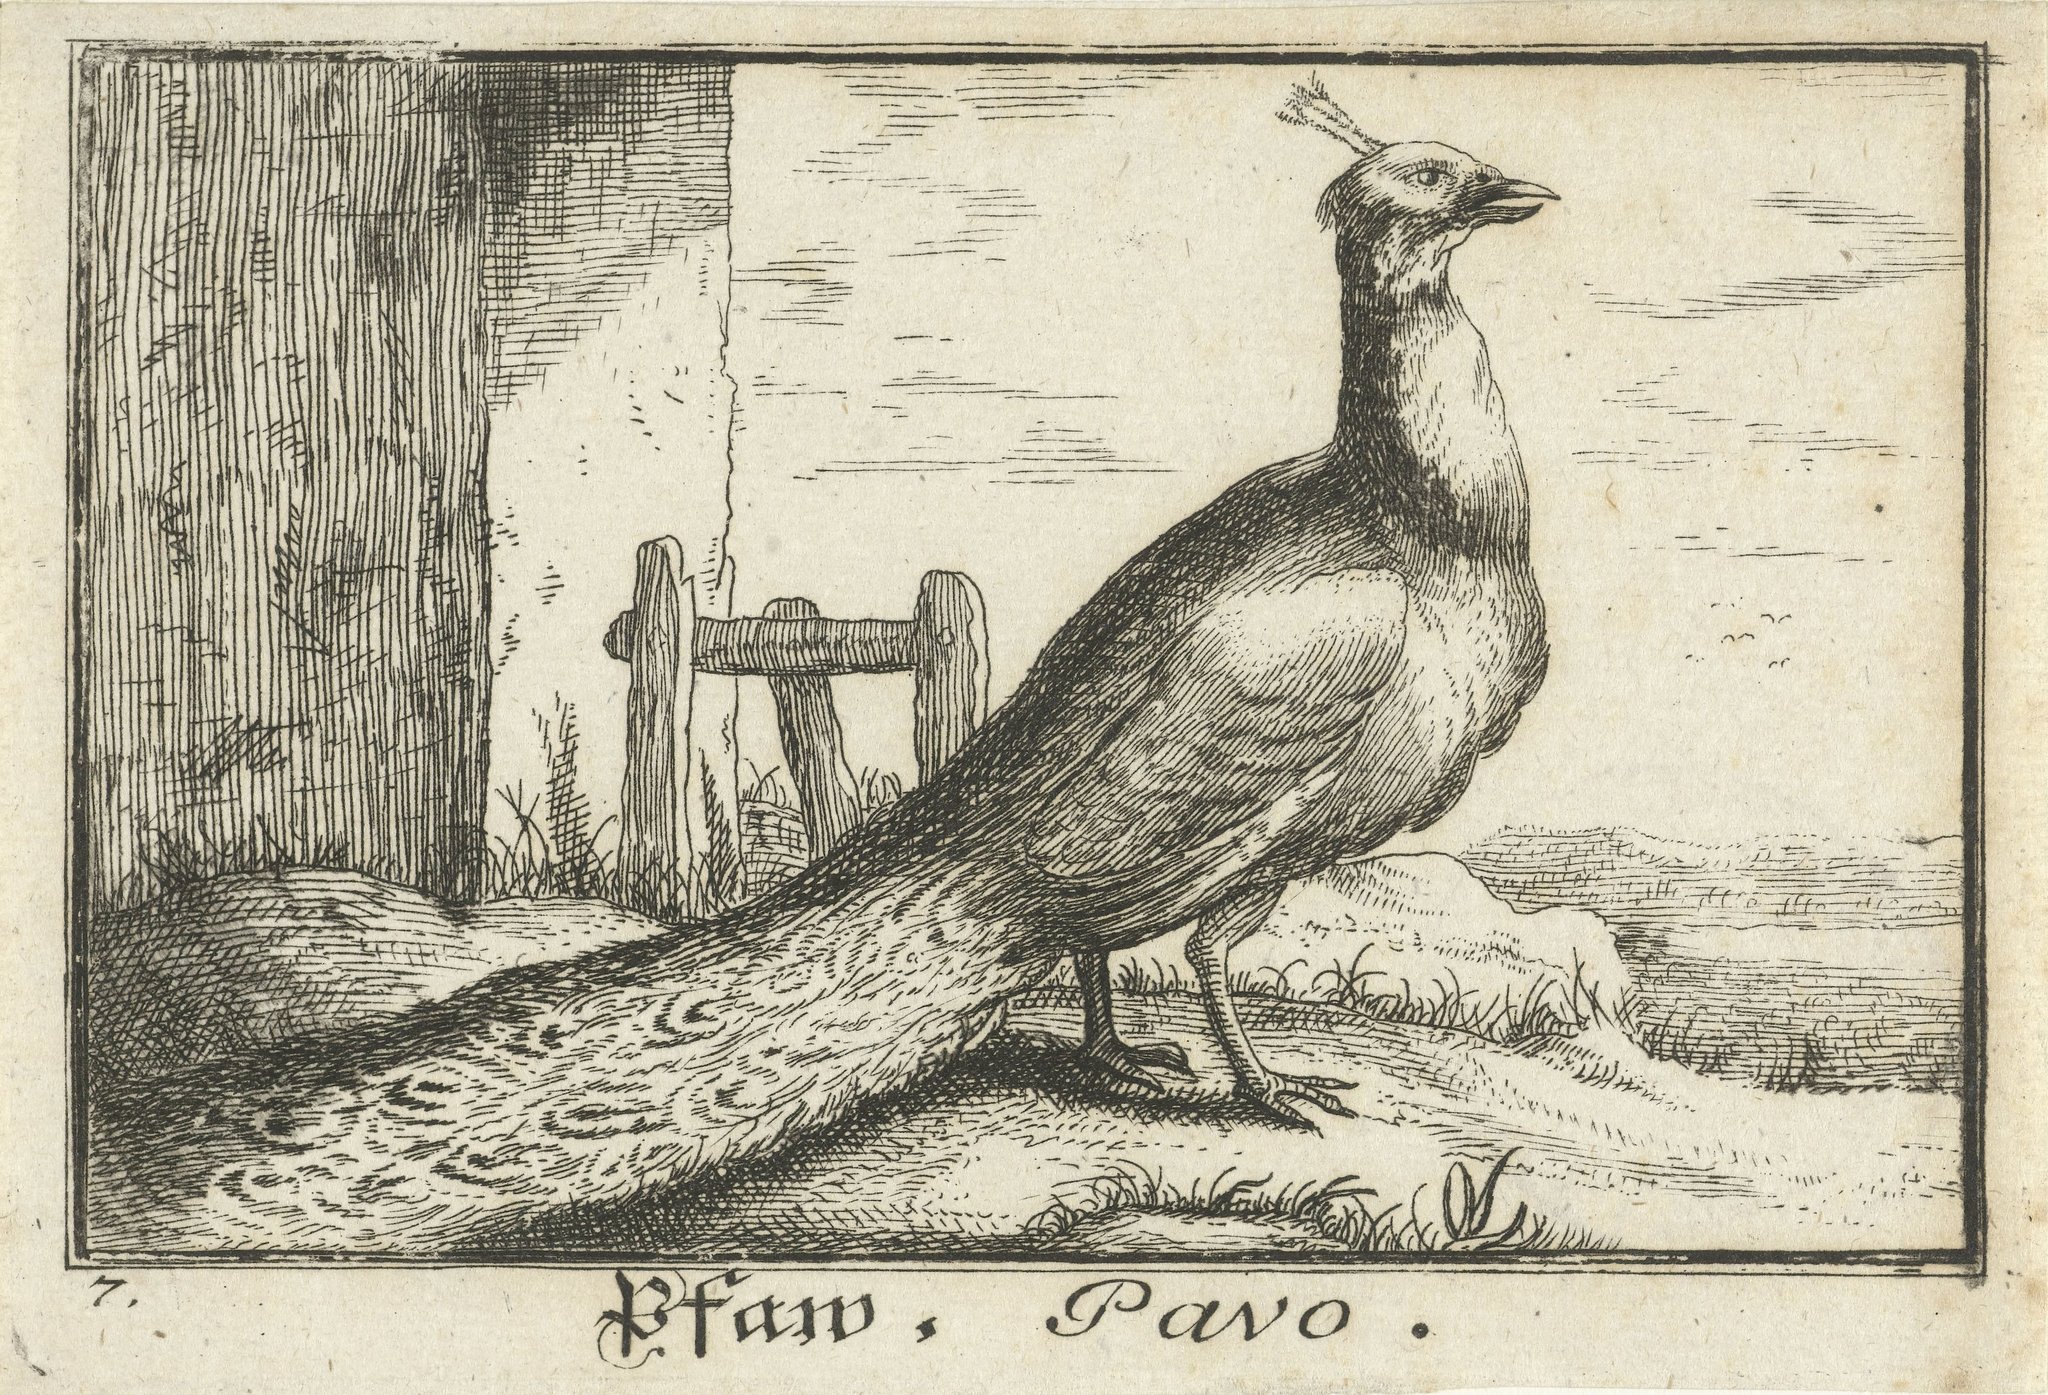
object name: print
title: Landschap met pauw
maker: Anonymous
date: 1659-1741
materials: paper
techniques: etching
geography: paris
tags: ornamental birds: peacock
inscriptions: collector's mark: Lugt 240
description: Kopie in spiegelbeeld naar een prent uit de serie Dertien vogelsoorten van Albert Flamen.